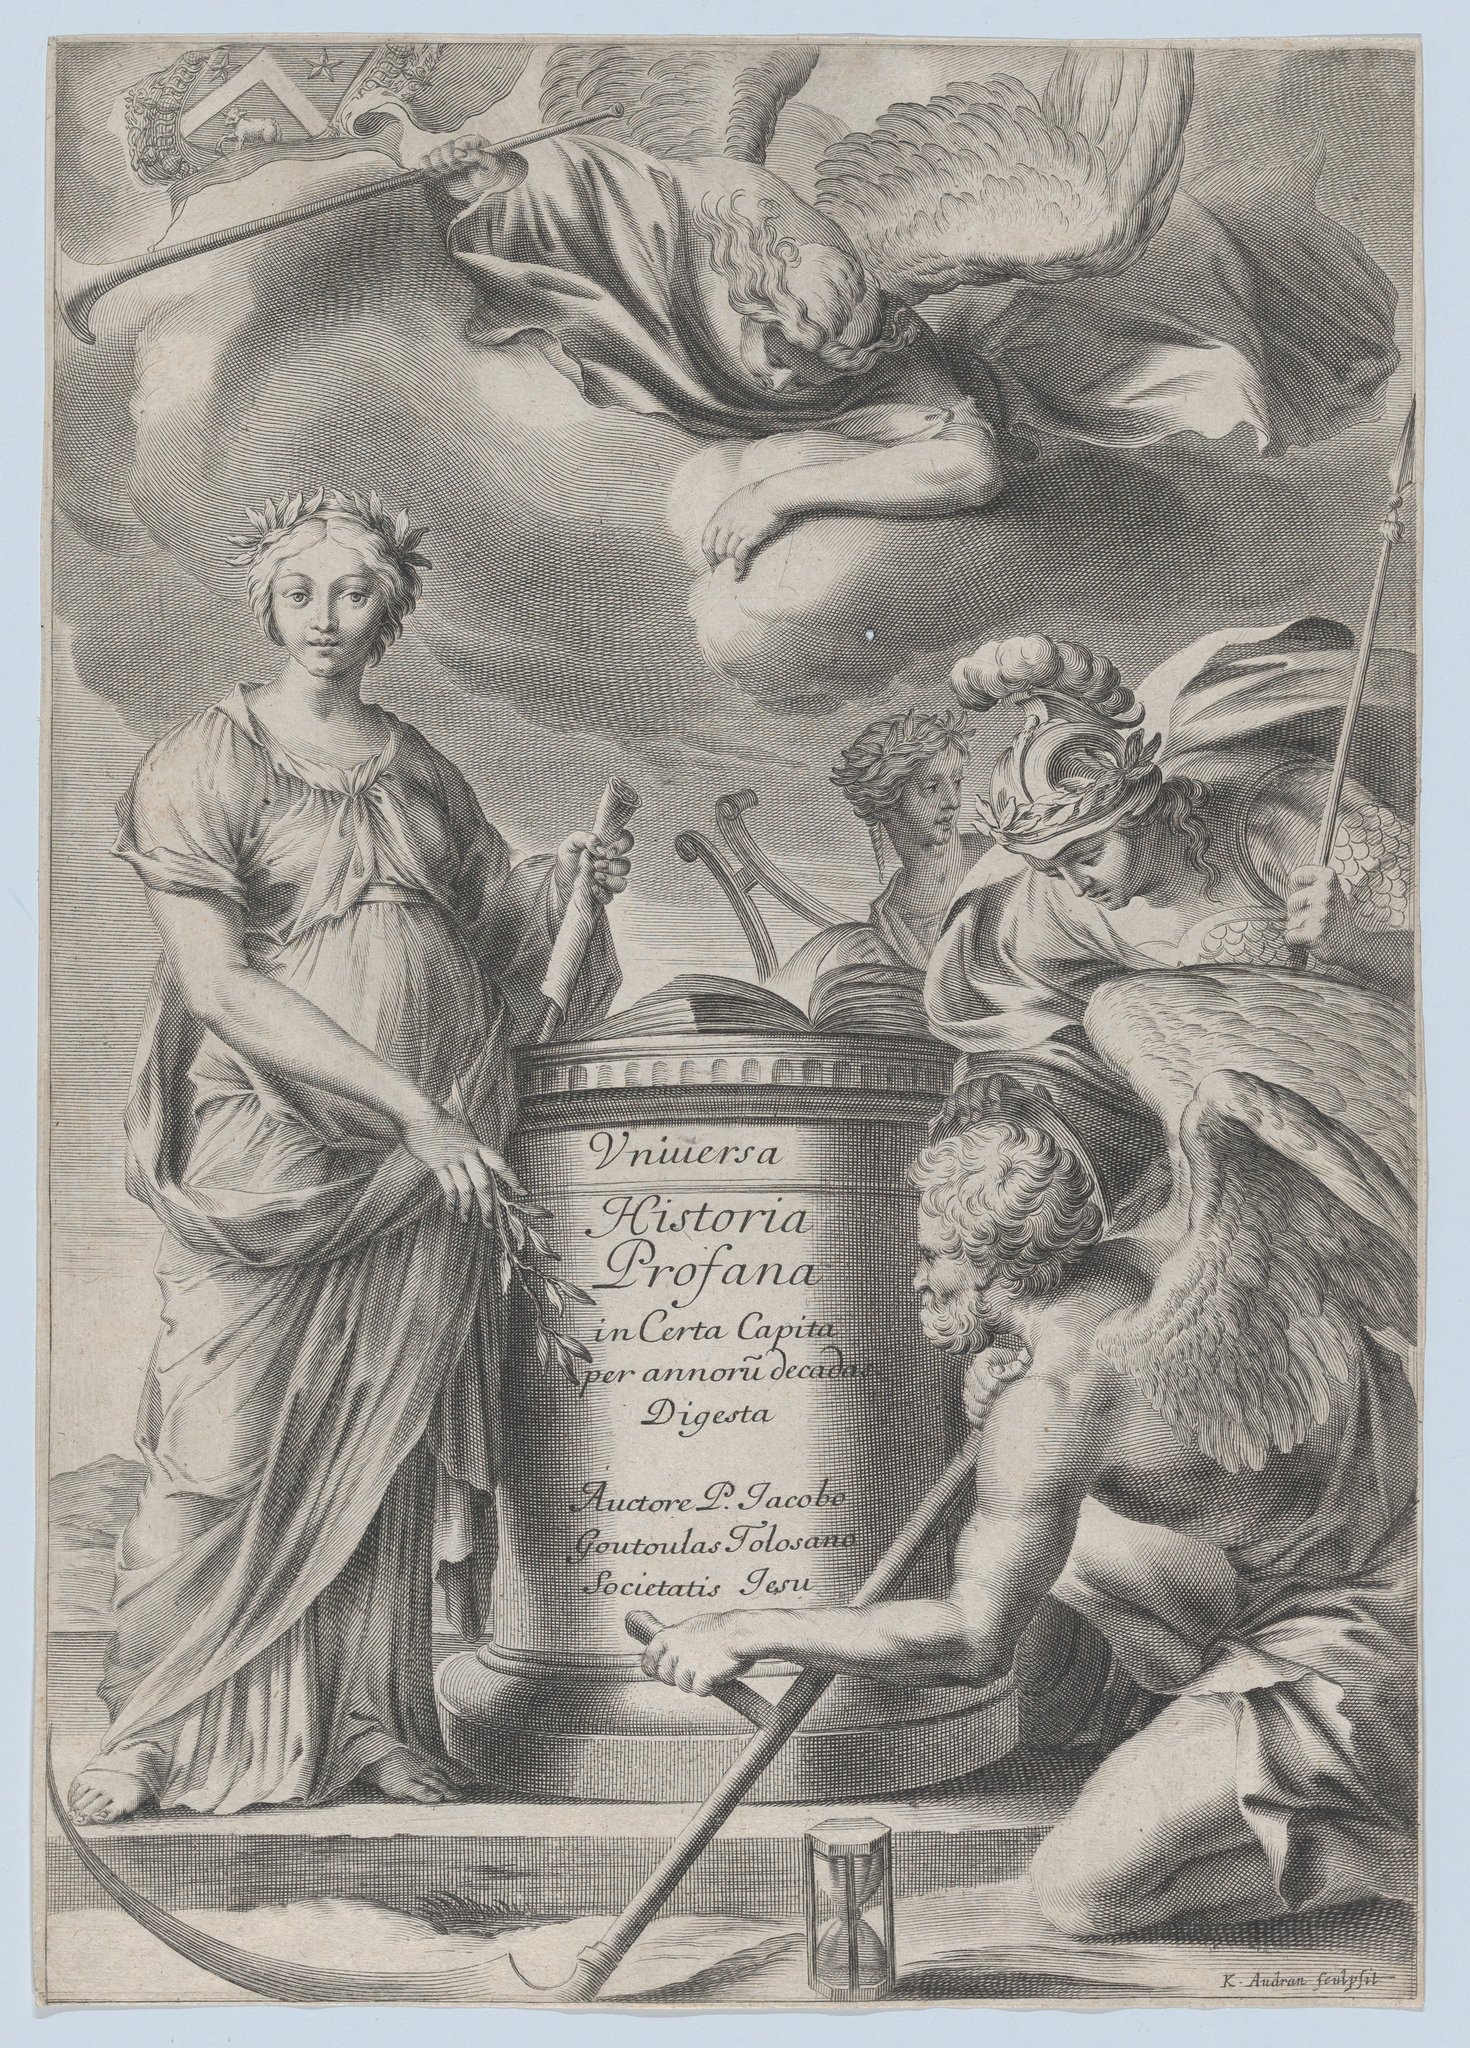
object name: print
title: Frontispiece for Vnuiersa Historia Profana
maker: charles audran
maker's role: artist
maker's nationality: french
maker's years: 1594-1674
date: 1630-1670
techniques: etching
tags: women